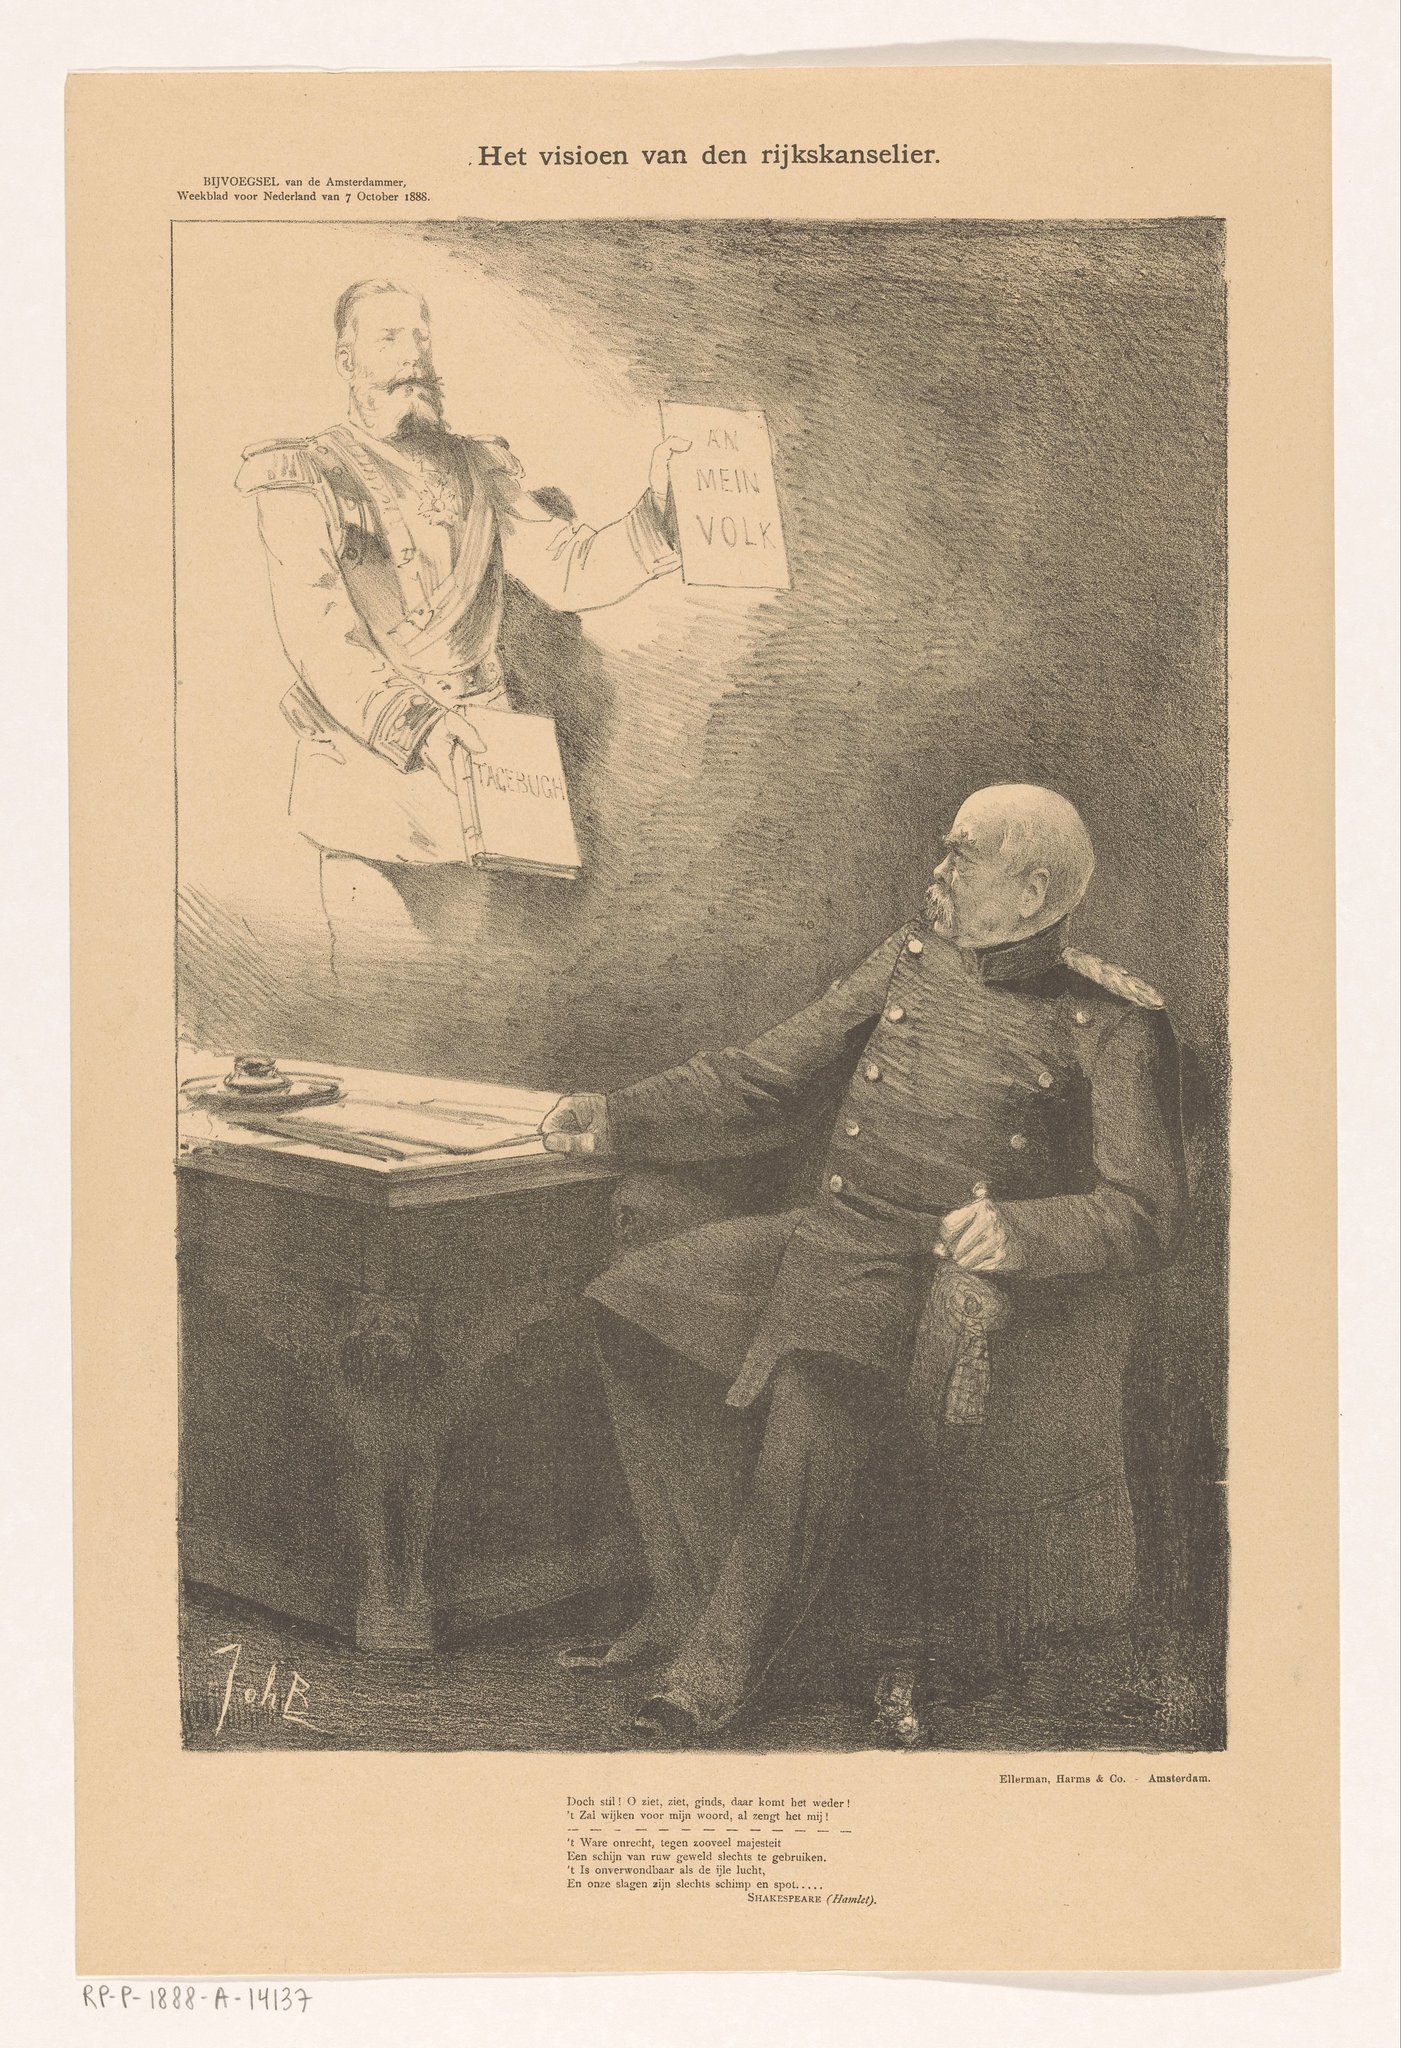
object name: print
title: Het visioen van den Rijkskanselier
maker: johan braakensiek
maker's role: draughtsman, print maker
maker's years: 1858-1940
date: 1888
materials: paper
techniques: lithograph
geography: amsterdam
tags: berlin, frederik willem iii koning van pruisen, vision, political caricatures and satires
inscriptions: collector's mark: Lugt 2228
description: Otto von Bismarck heeft een visioen van Frederik III van Pruisen. Frederik III houdt in zijn rechterhand zijn dagboek vast. Met zijn linkerhand houdt hij de proclamatie 'An mein Volk' omhoog, geschreven door zijn grootvader Frederik Willem III van Pruisen.